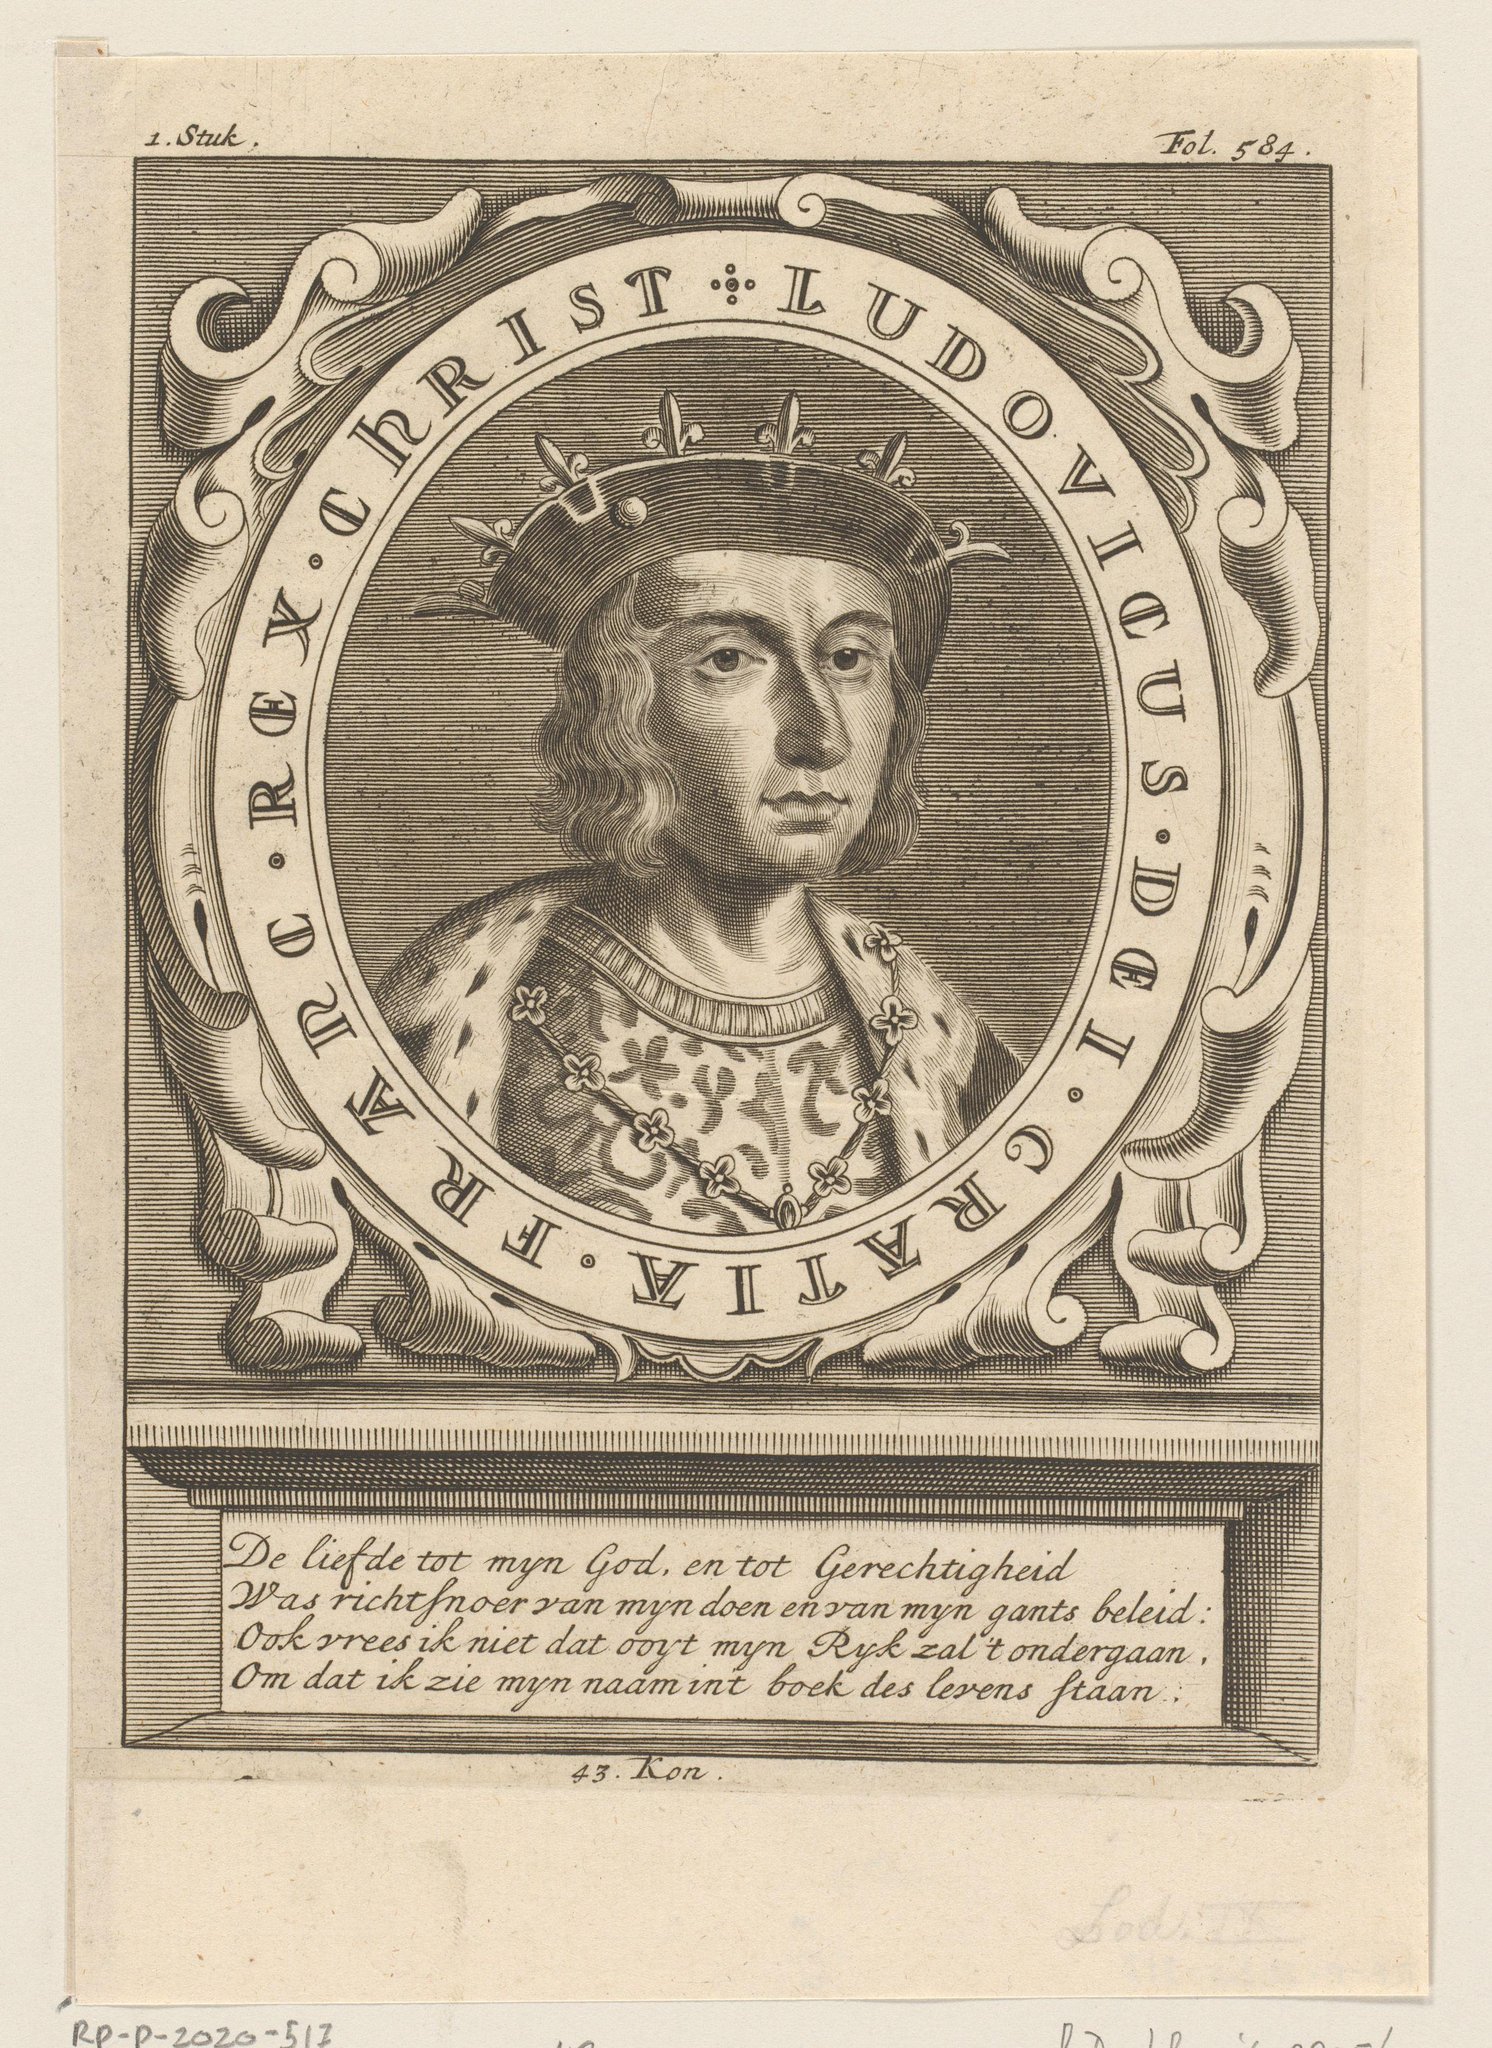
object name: book illustration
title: Portret van Lodewijk IX de Heilige, koning van Frankrijk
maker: Anonymous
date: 1685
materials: paper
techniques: engraving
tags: historical persons, king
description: Prent gebruikt in: Eudes de Mézeray, François. Chronyk van Vrankryk. 6 dln. Amsterdam: Jan Bouman en Timotheum ten Hoorn, 1685, dl. 2.